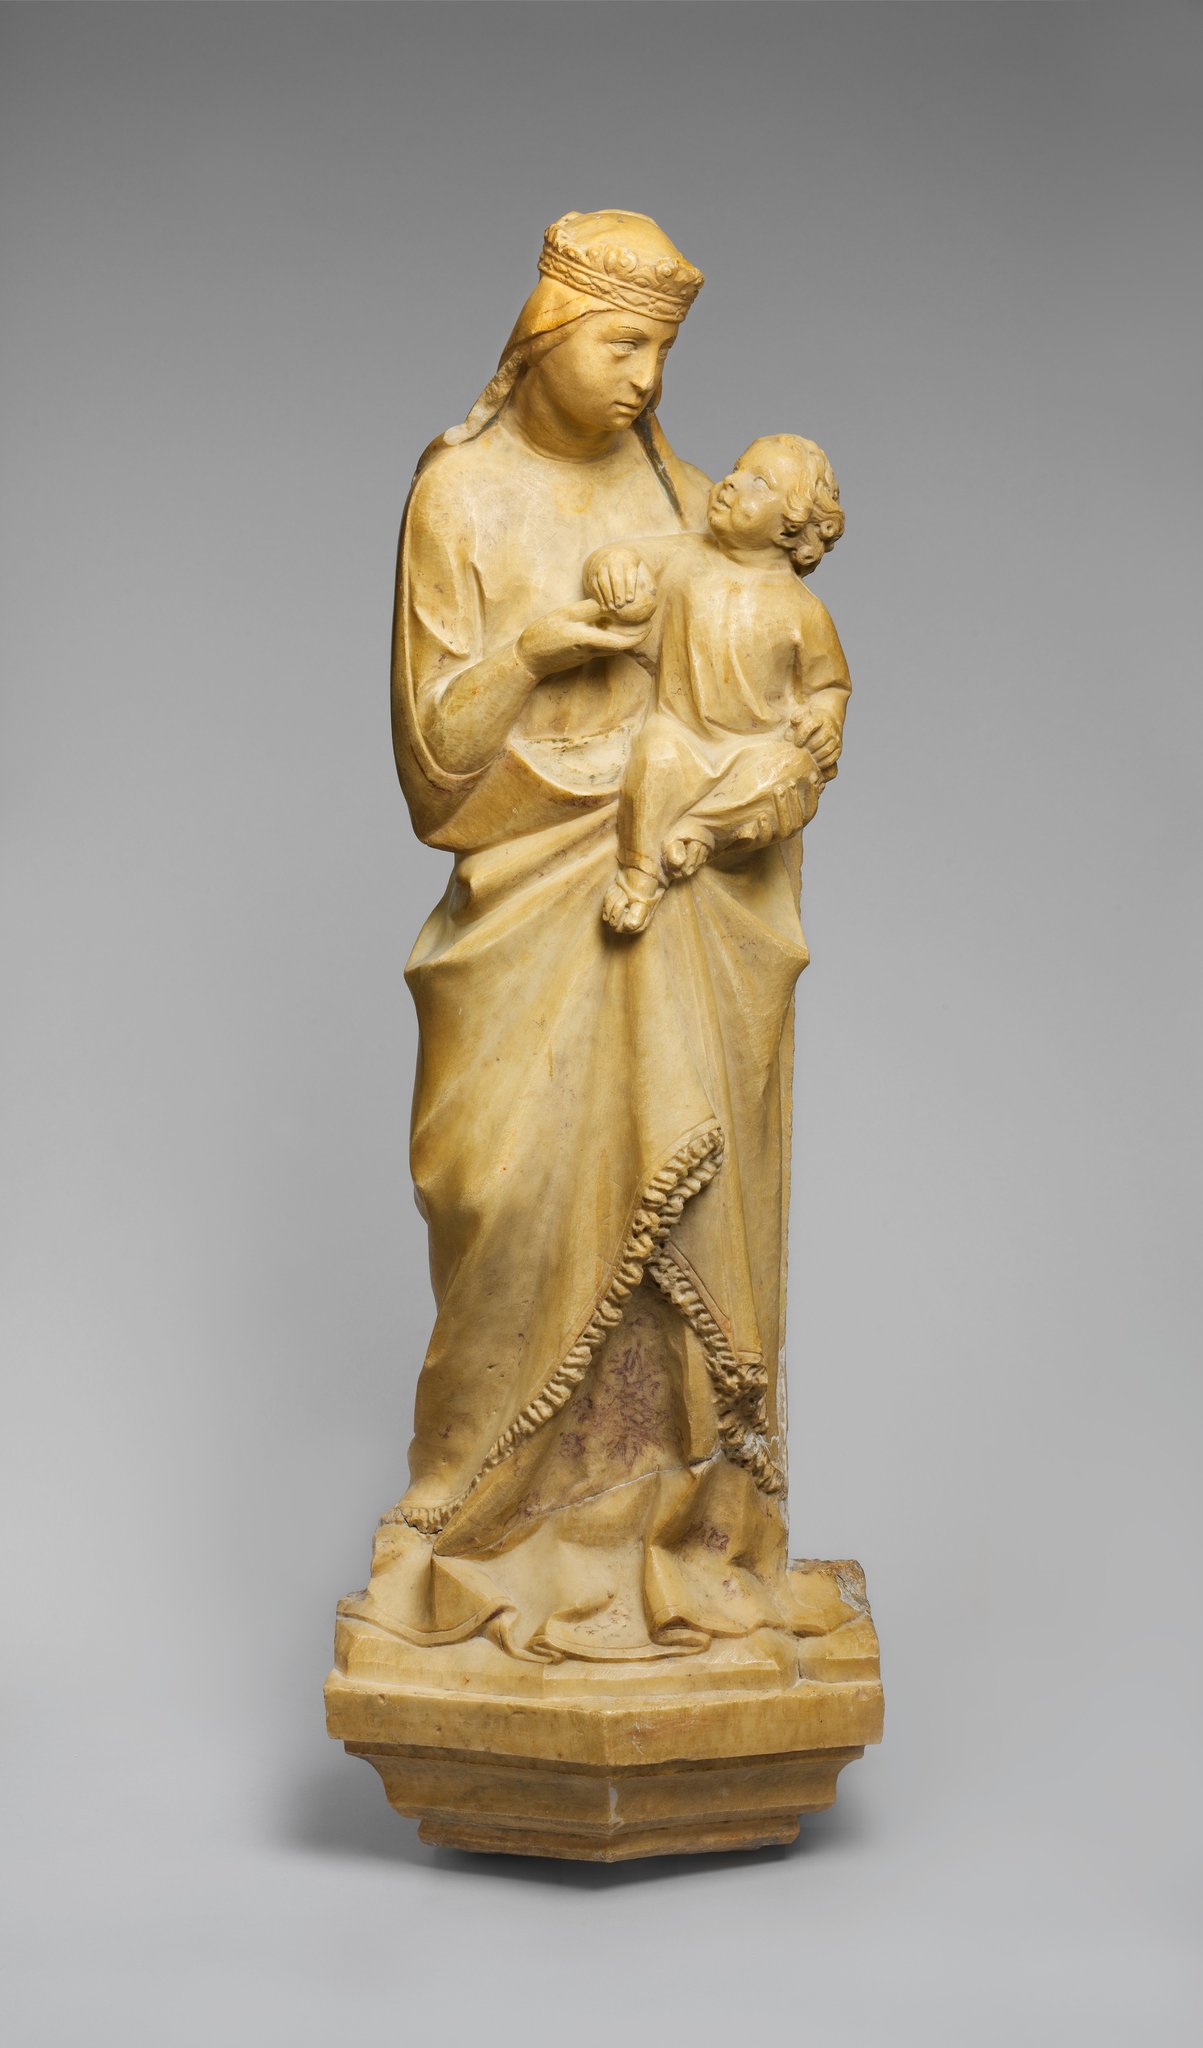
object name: statuette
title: Standing Virgin and Child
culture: italian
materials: marble